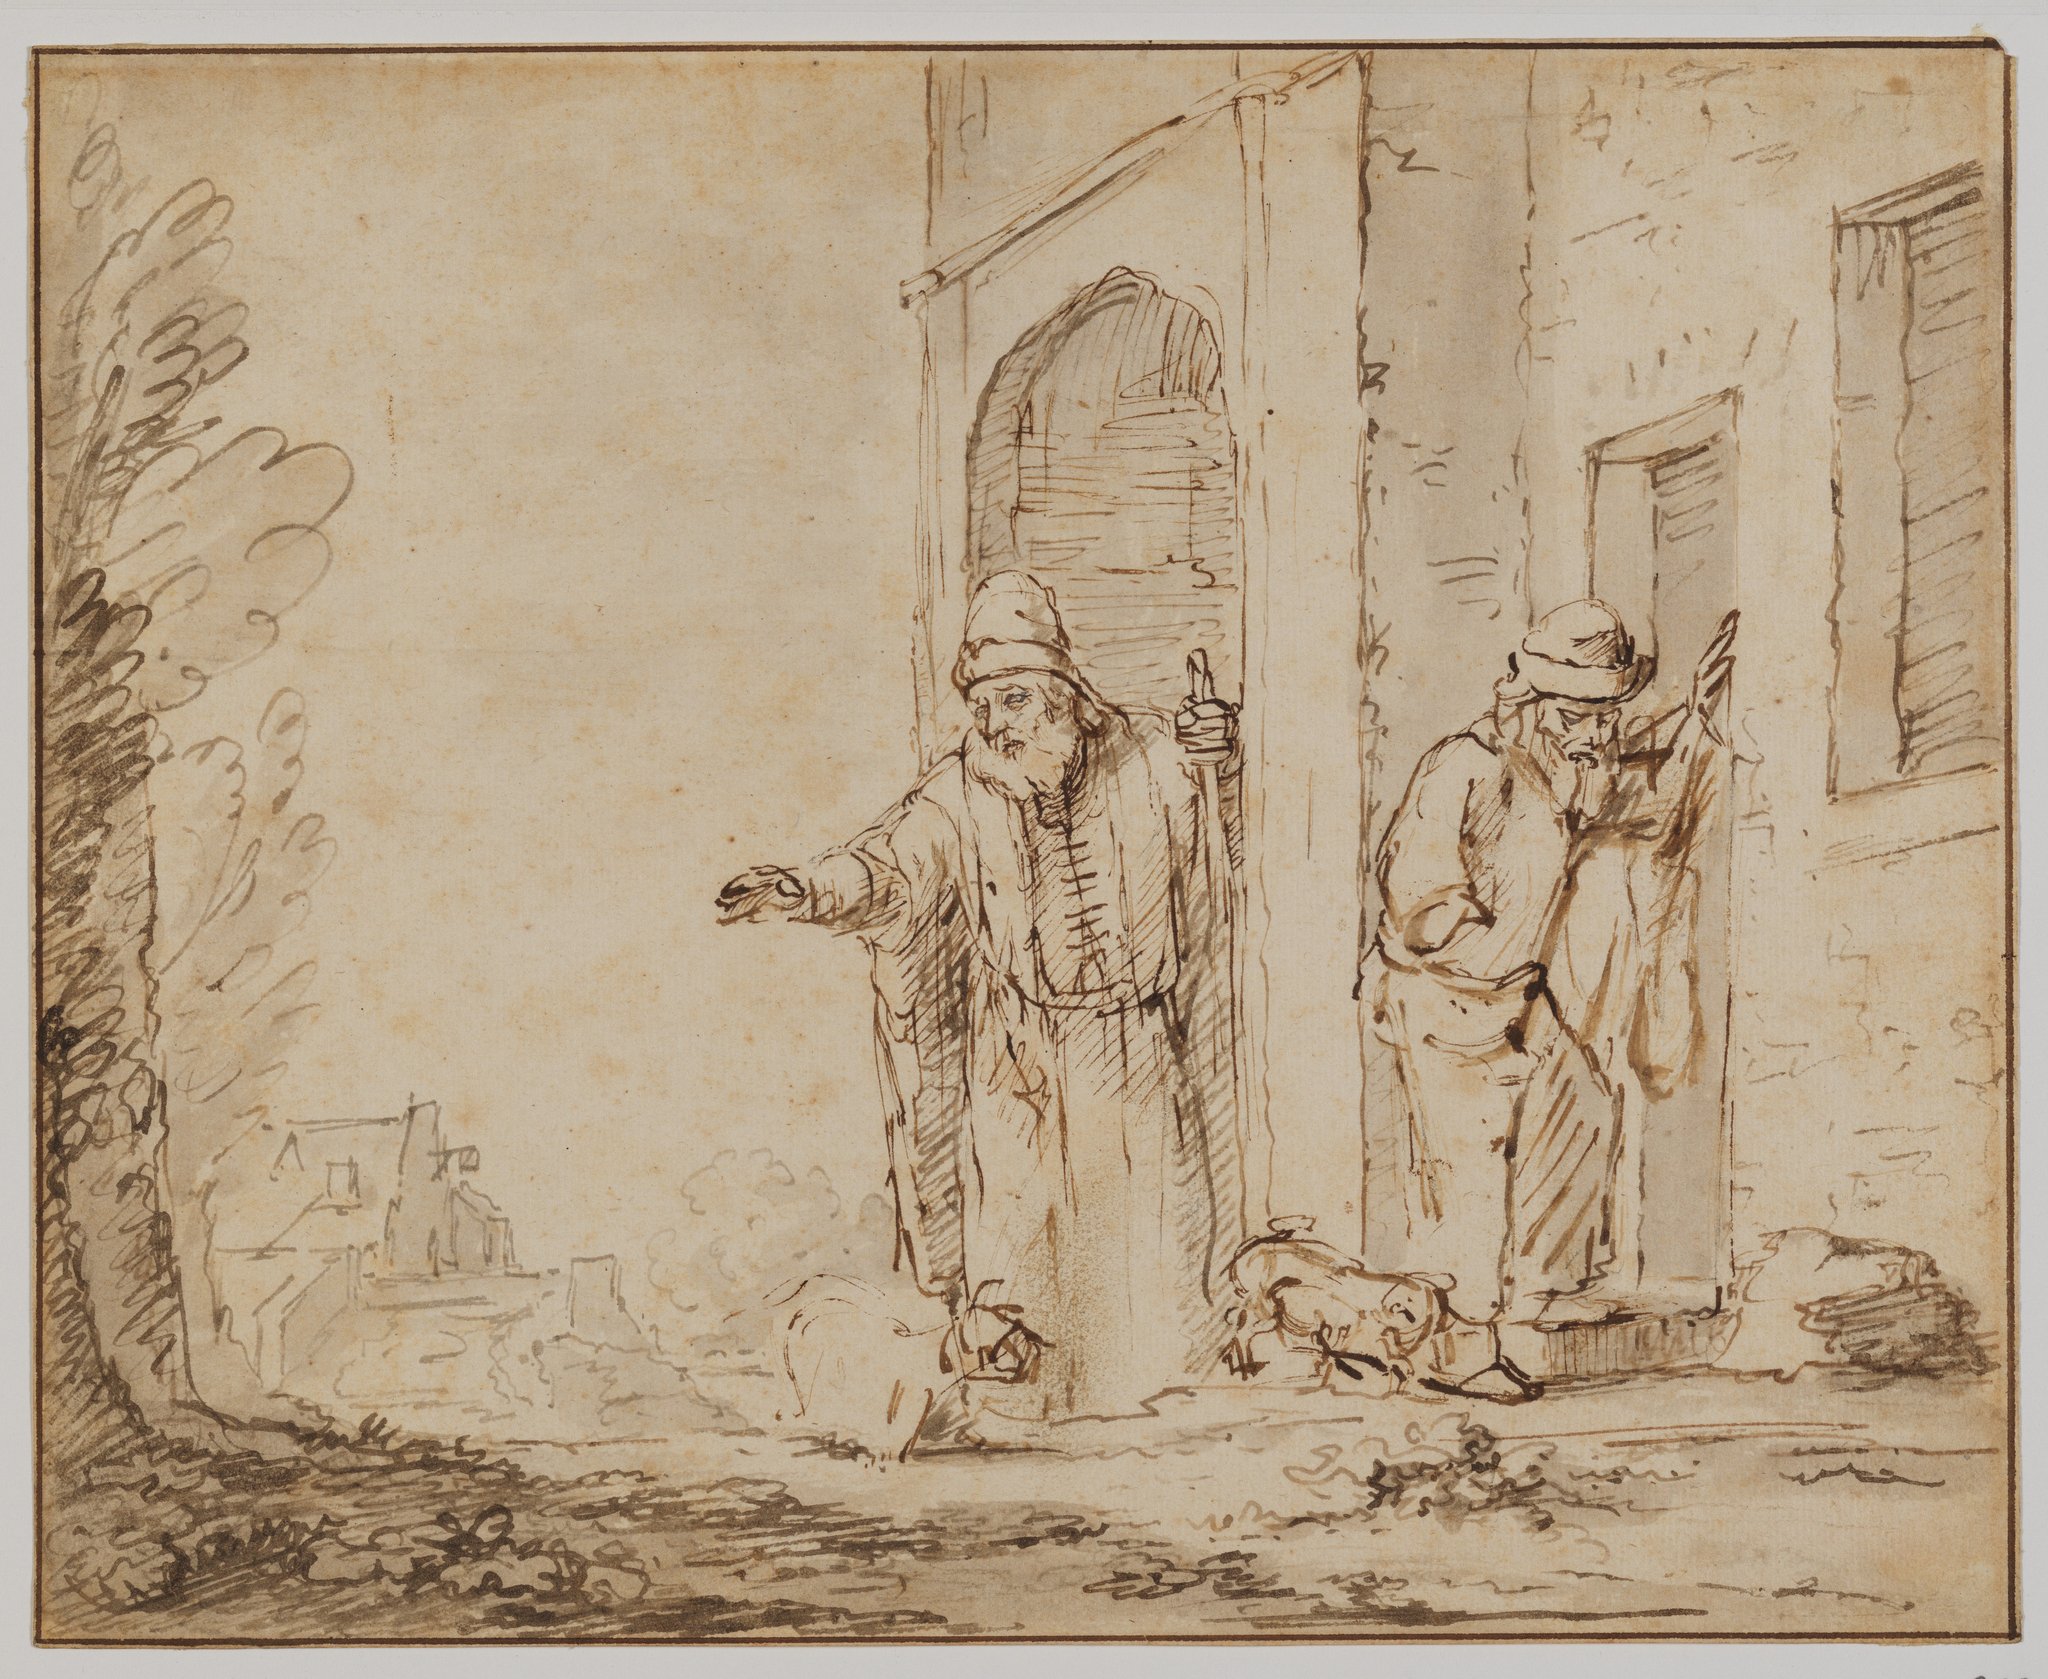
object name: drawing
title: Two Studies for Blind Tobit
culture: dutch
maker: school of rembrandt van rijn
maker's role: artist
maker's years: 1606-1669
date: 1651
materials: ink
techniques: pen, wash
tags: men